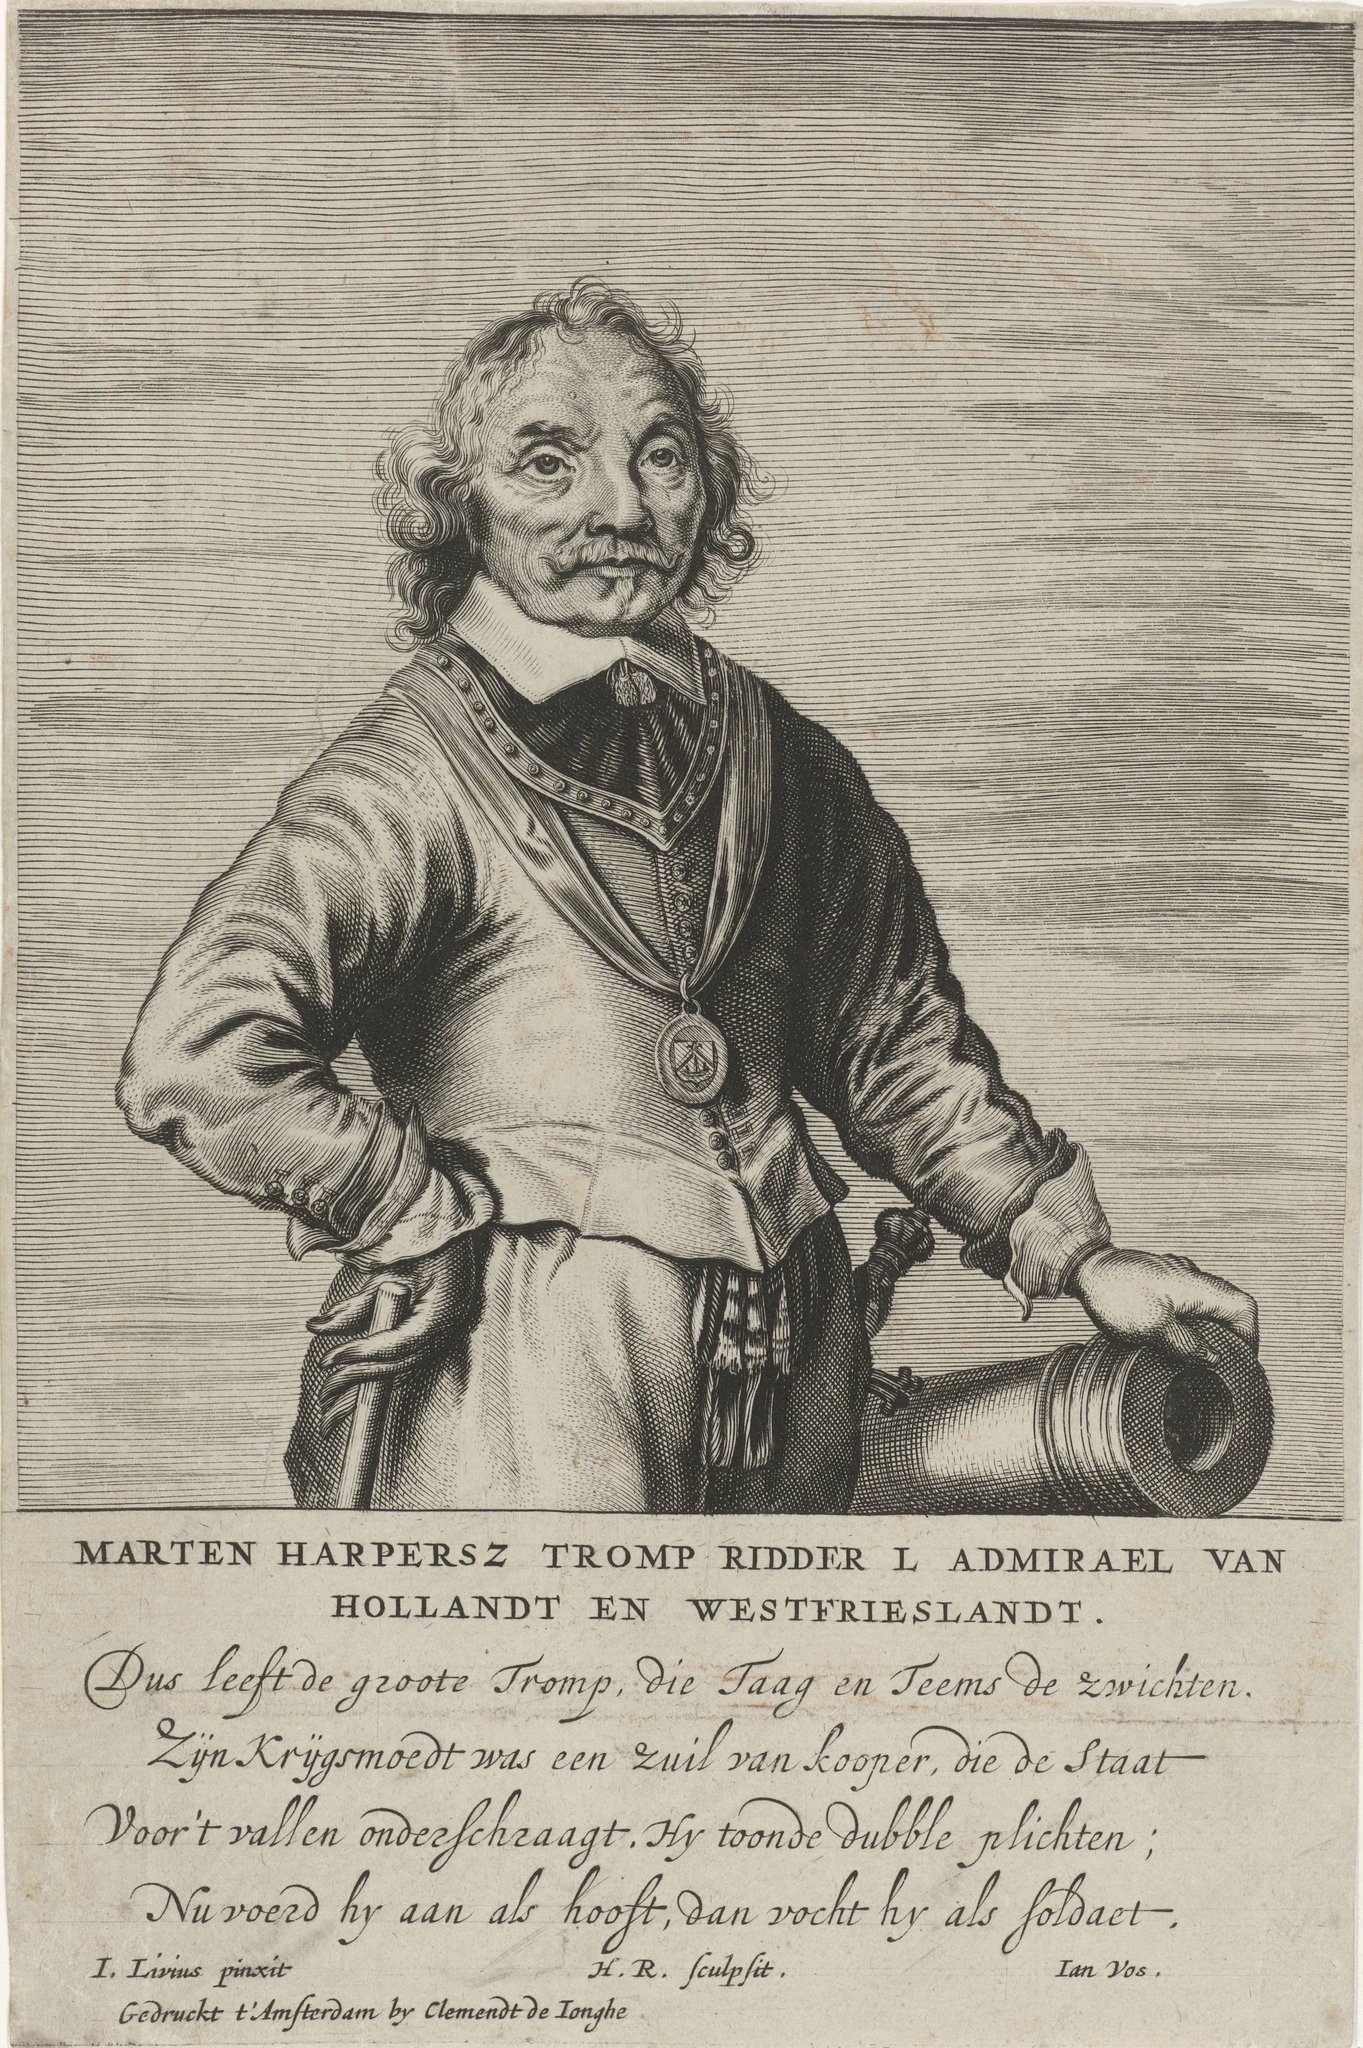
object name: print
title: Portret van Maarten Harpertszoon Tromp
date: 1644-1670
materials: paper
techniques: engraving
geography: northern netherlands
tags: brielle, maarten harpertszoon tromp, commander-in-chief, admiral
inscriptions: collector's mark: Lugt 240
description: Portret van admiraal Maarten Harpertszoon Tromp, staand naast een kanon. In de marge zijn naam, titel en een lofdicht.